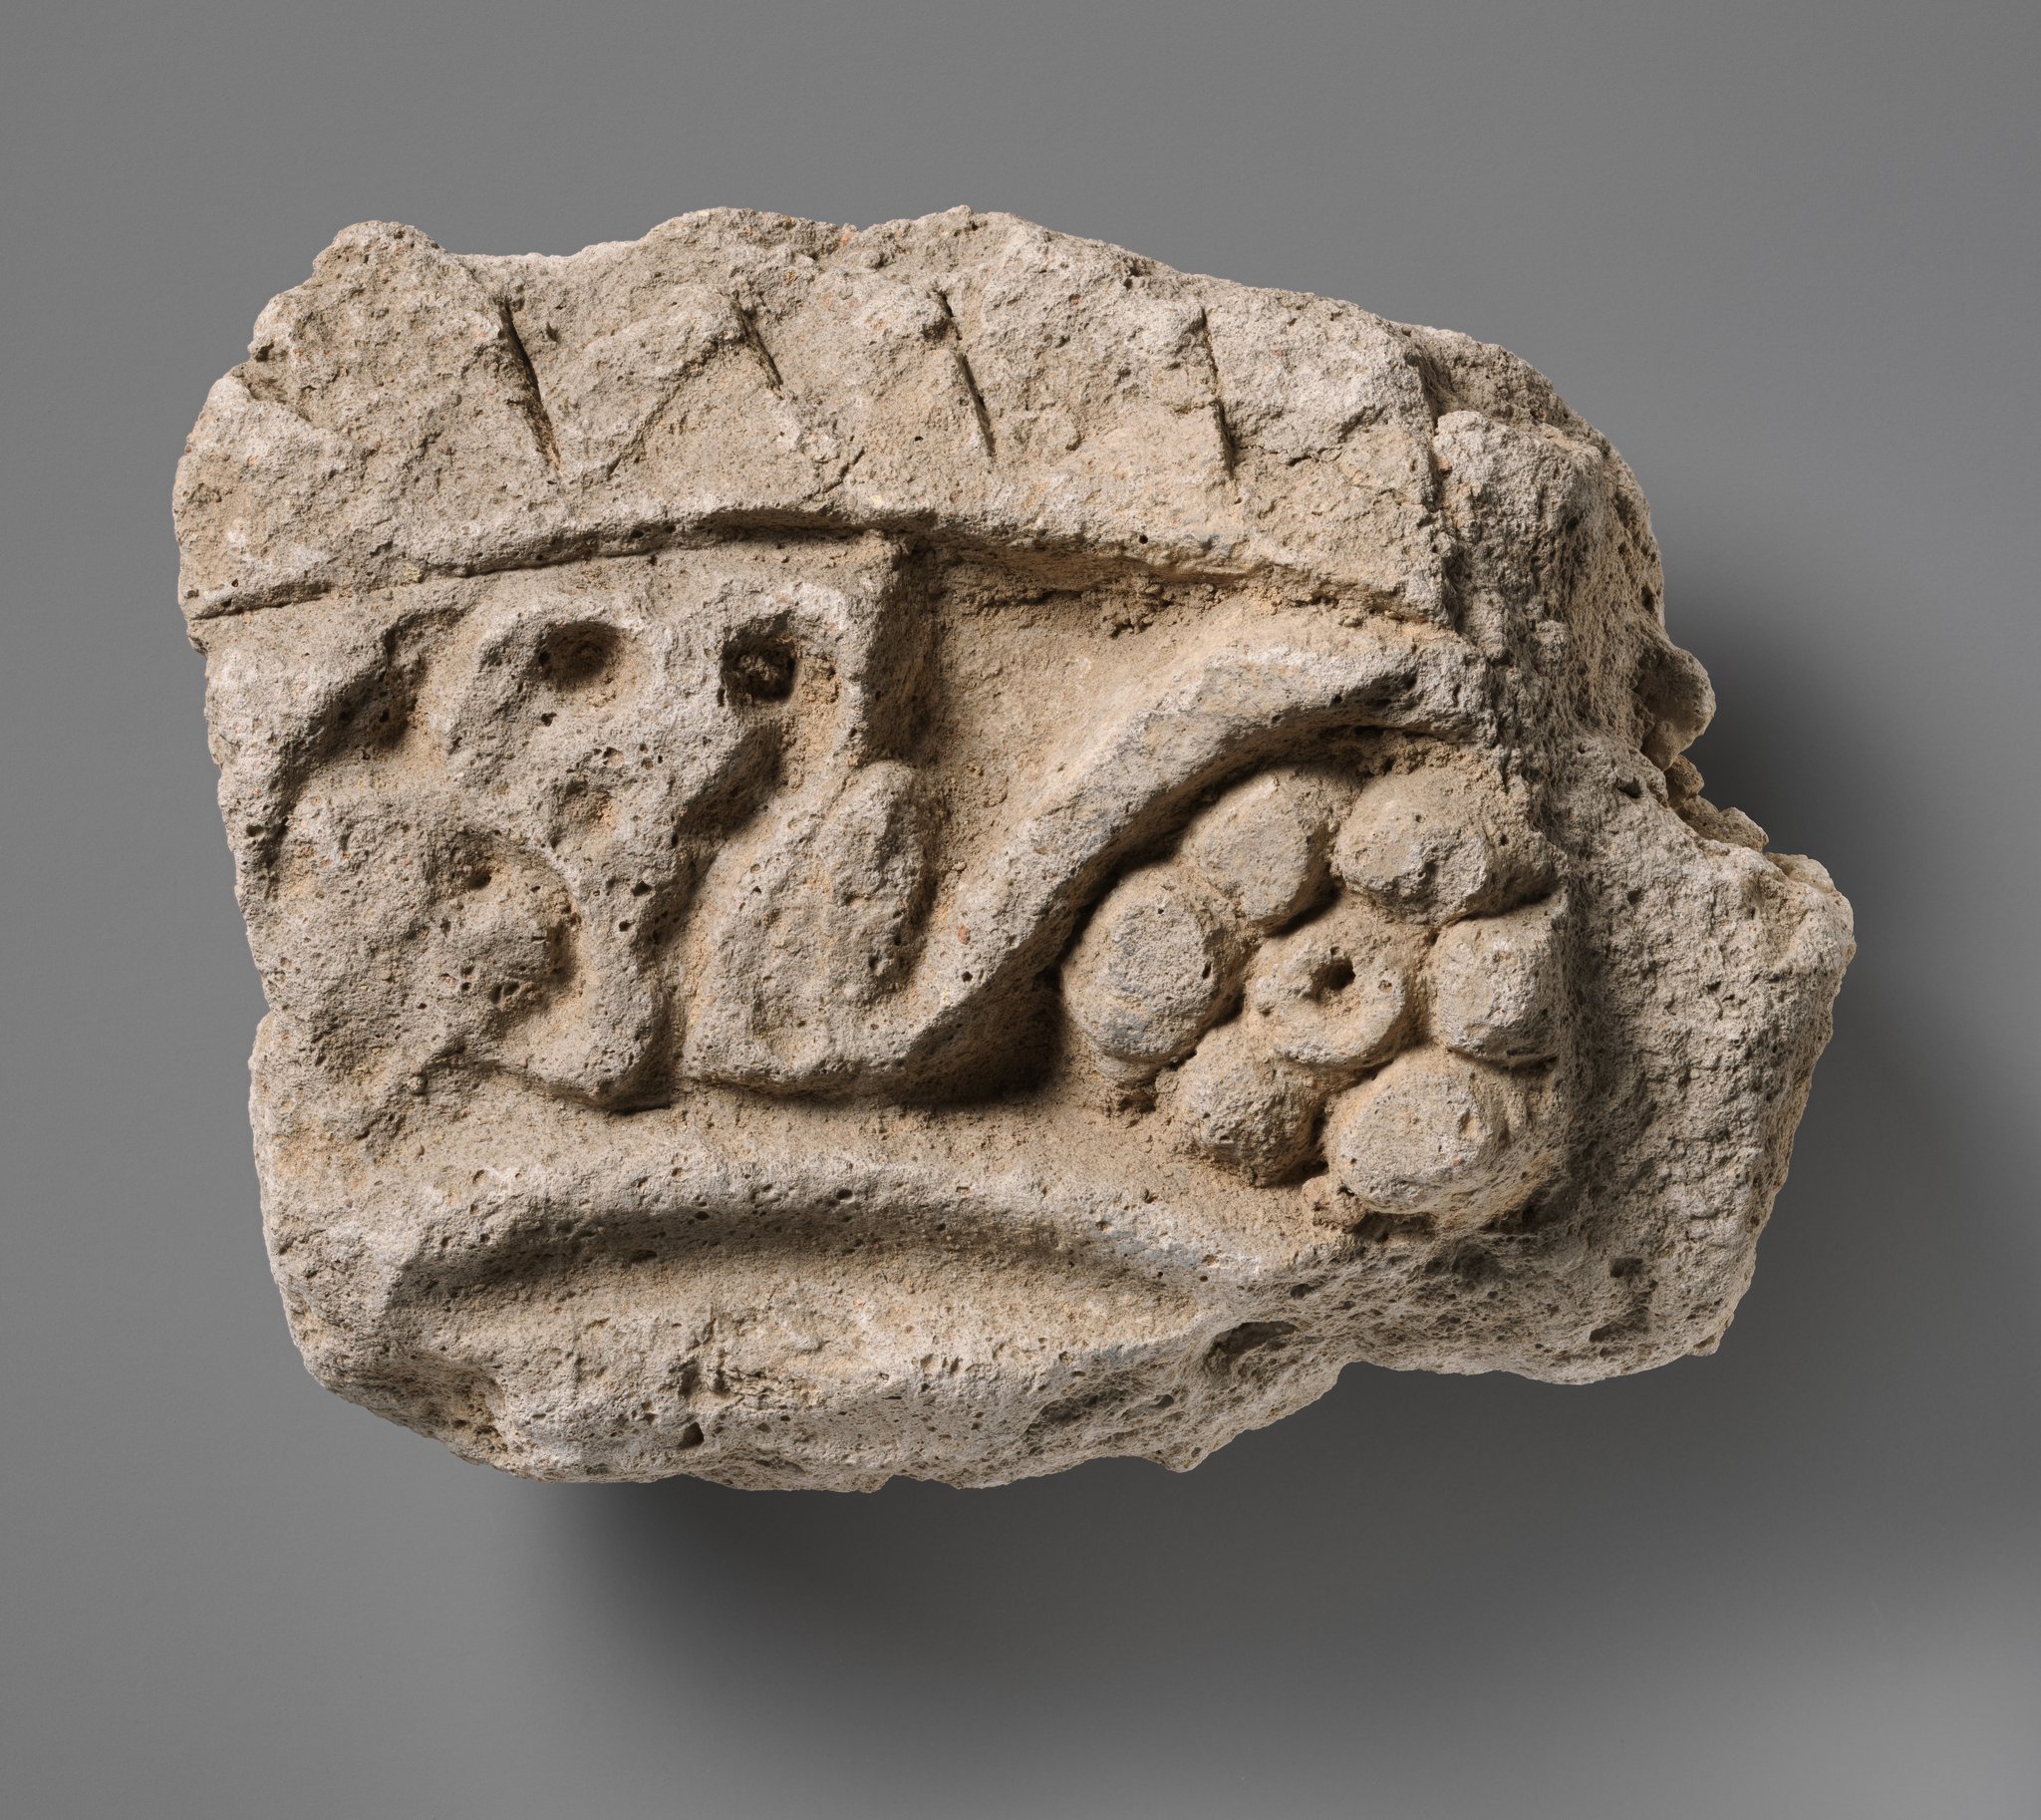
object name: relief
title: Relief fragment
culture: sasanian or islamic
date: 501-800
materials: plaster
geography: mesopotamia